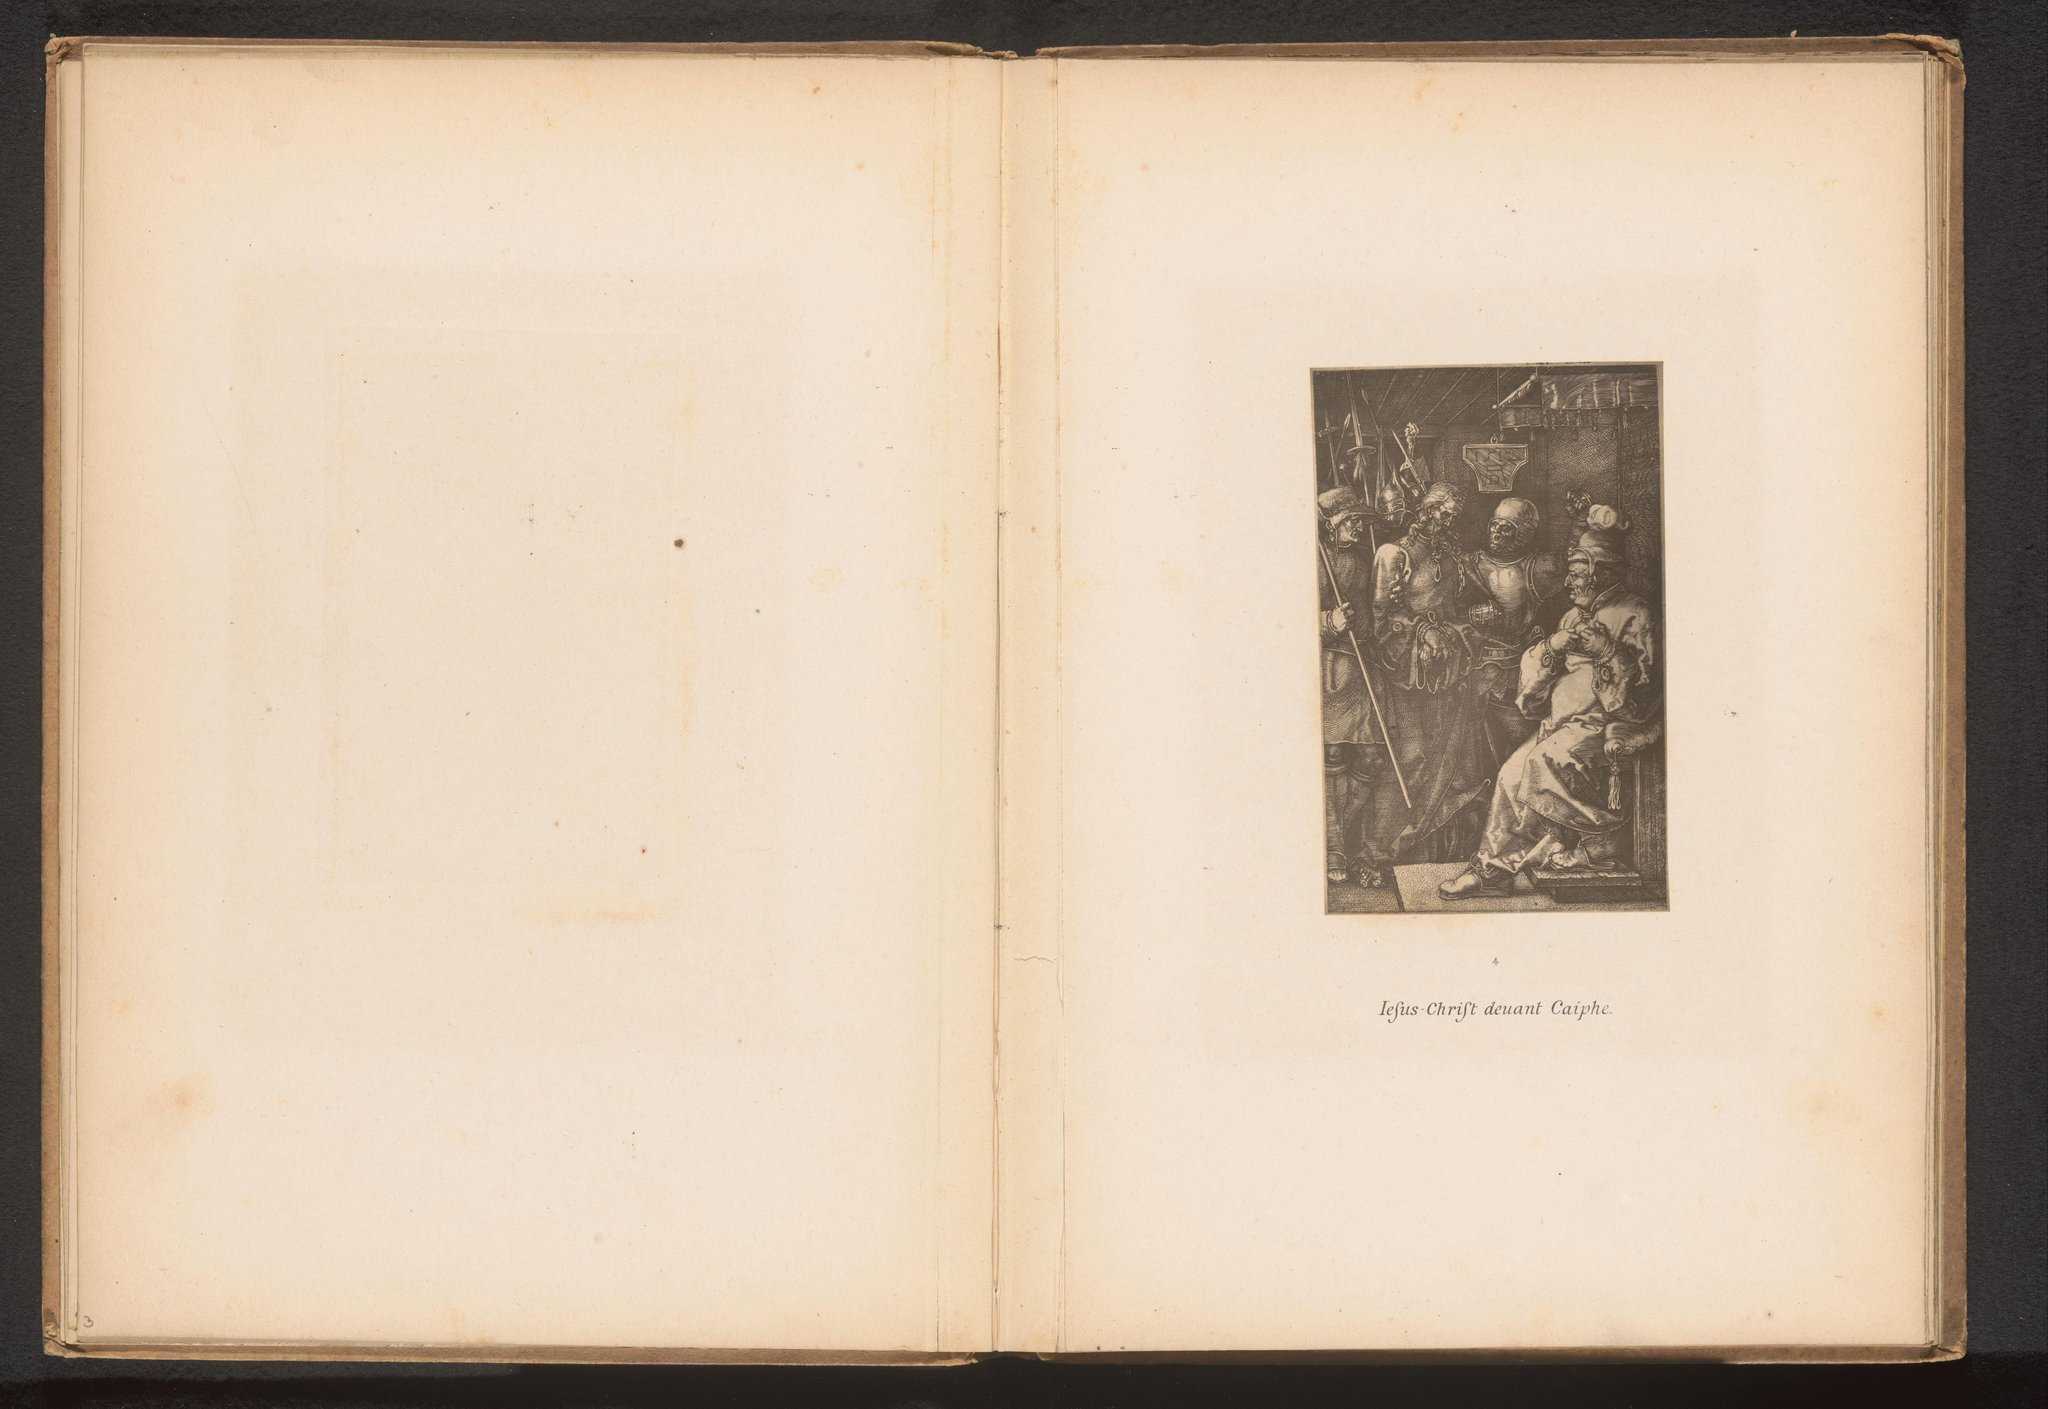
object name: photomechanical print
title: Reproductie van Christus voor Kajafas door Albrecht Dürer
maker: albrecht dürer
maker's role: draughtsman, painter, print maker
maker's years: 1471-1528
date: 1866-1871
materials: paper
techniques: woodburytype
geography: nuremberg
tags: christ before the sanhedrin with caiaphas as high priest, and possibly annas; maybe a soldier about to strike christ because he keeps silent (matthew 26:57-66; mark 14:53-64; luke 22:54, 22:66-71), passion of christ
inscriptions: number: ‘4’